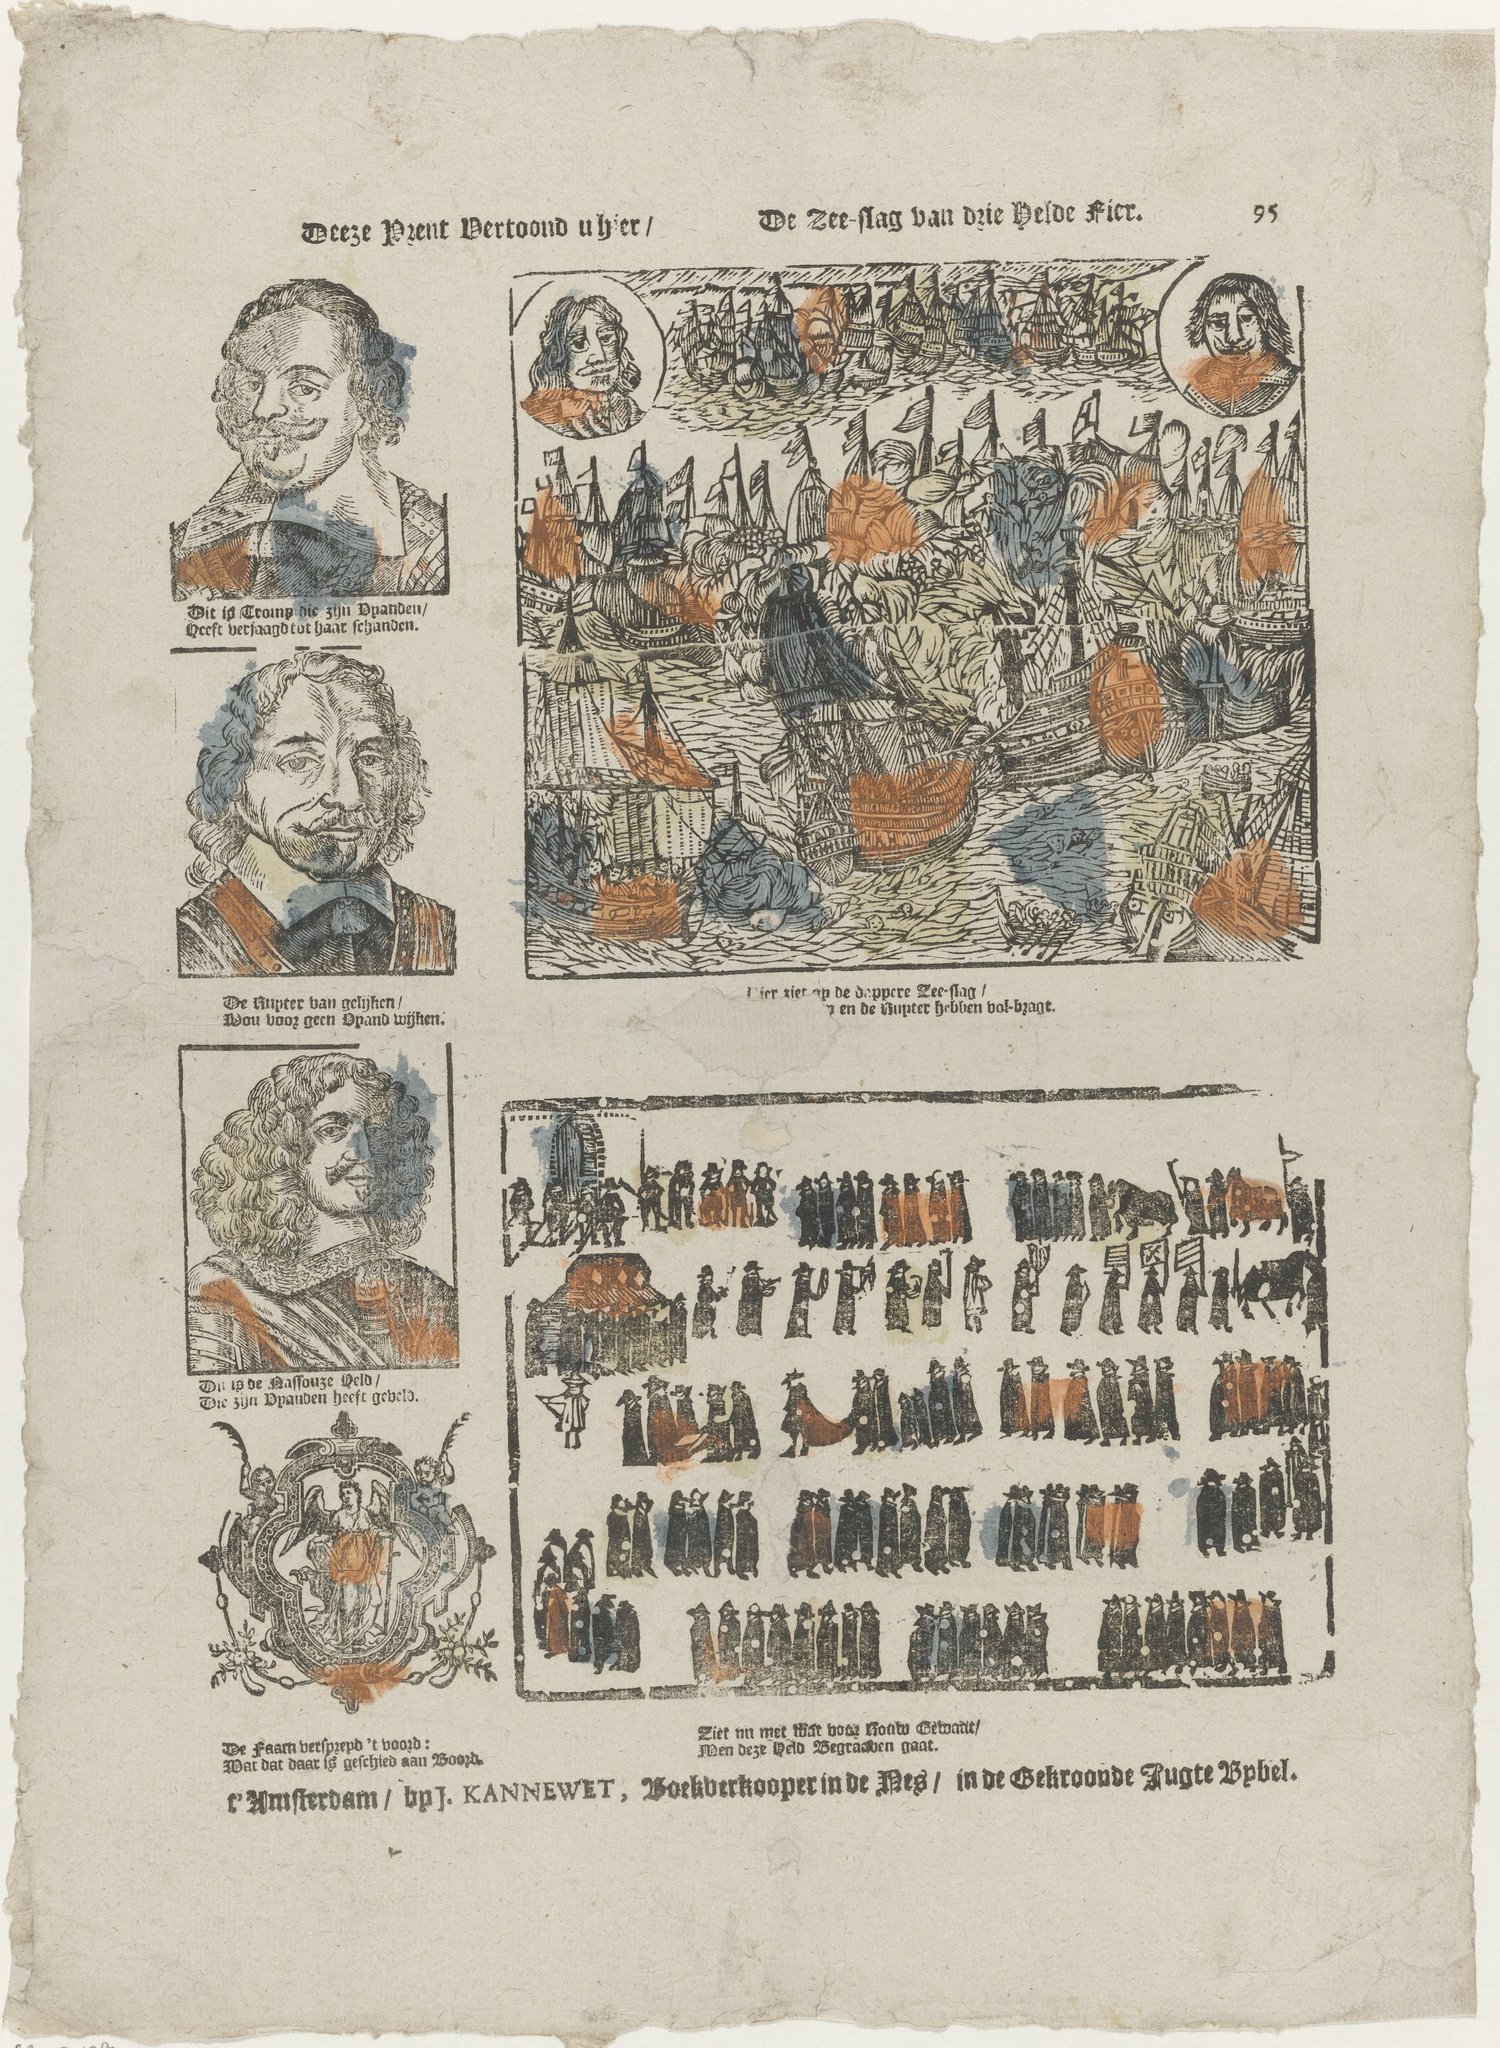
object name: popular print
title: Deze prent vertoond u hier / De zee-slag van drie helde fier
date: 1725-1780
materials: paper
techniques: colour, letterpress printing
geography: amsterdam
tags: flushing, michiel adriaenszoon de ruyter, rotterdam, amsterdam, cornelis tromp, commander-in-chief, admiral (+ naval force), battle (+ naval force), ships (in general)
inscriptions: collector's mark: Lugt 2760, collector's mark: Lugt 2228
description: Blad met 6 voorstellingen van zeetaferelen en portretten van de luitenant-admiraals-generaal Cornelis Tromp, Michiel Adriaenszoon de Ruyter en een graaf van Nassau. Onder elke afbeelding een tweeregelig vers. Genummerd rechtsboven: 95.